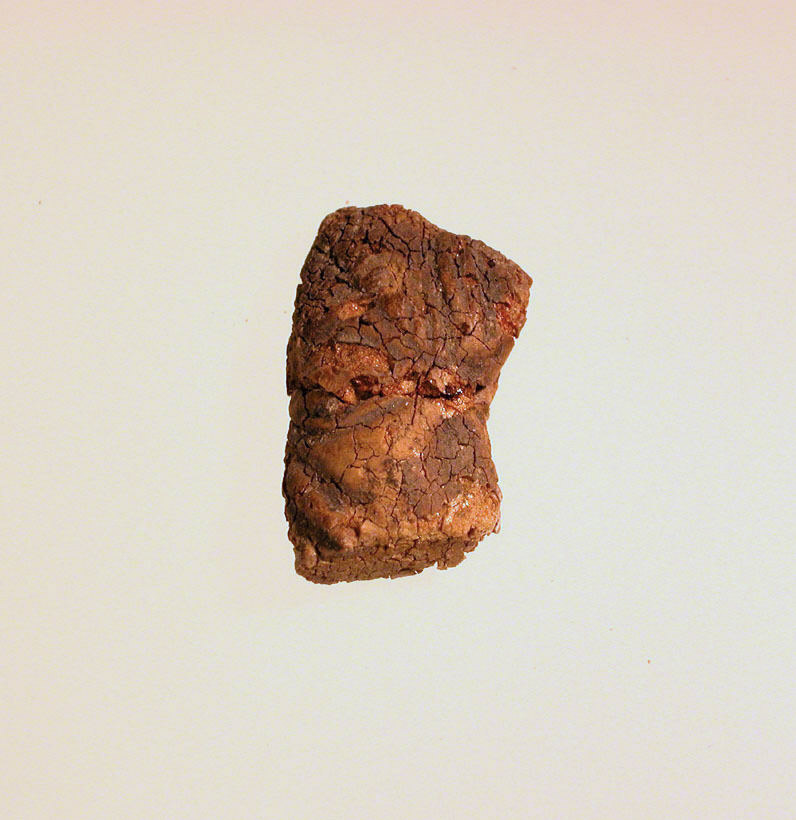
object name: head of a satyr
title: Pendant: head of a satyr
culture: italic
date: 500-401 BCE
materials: amber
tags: satyrs